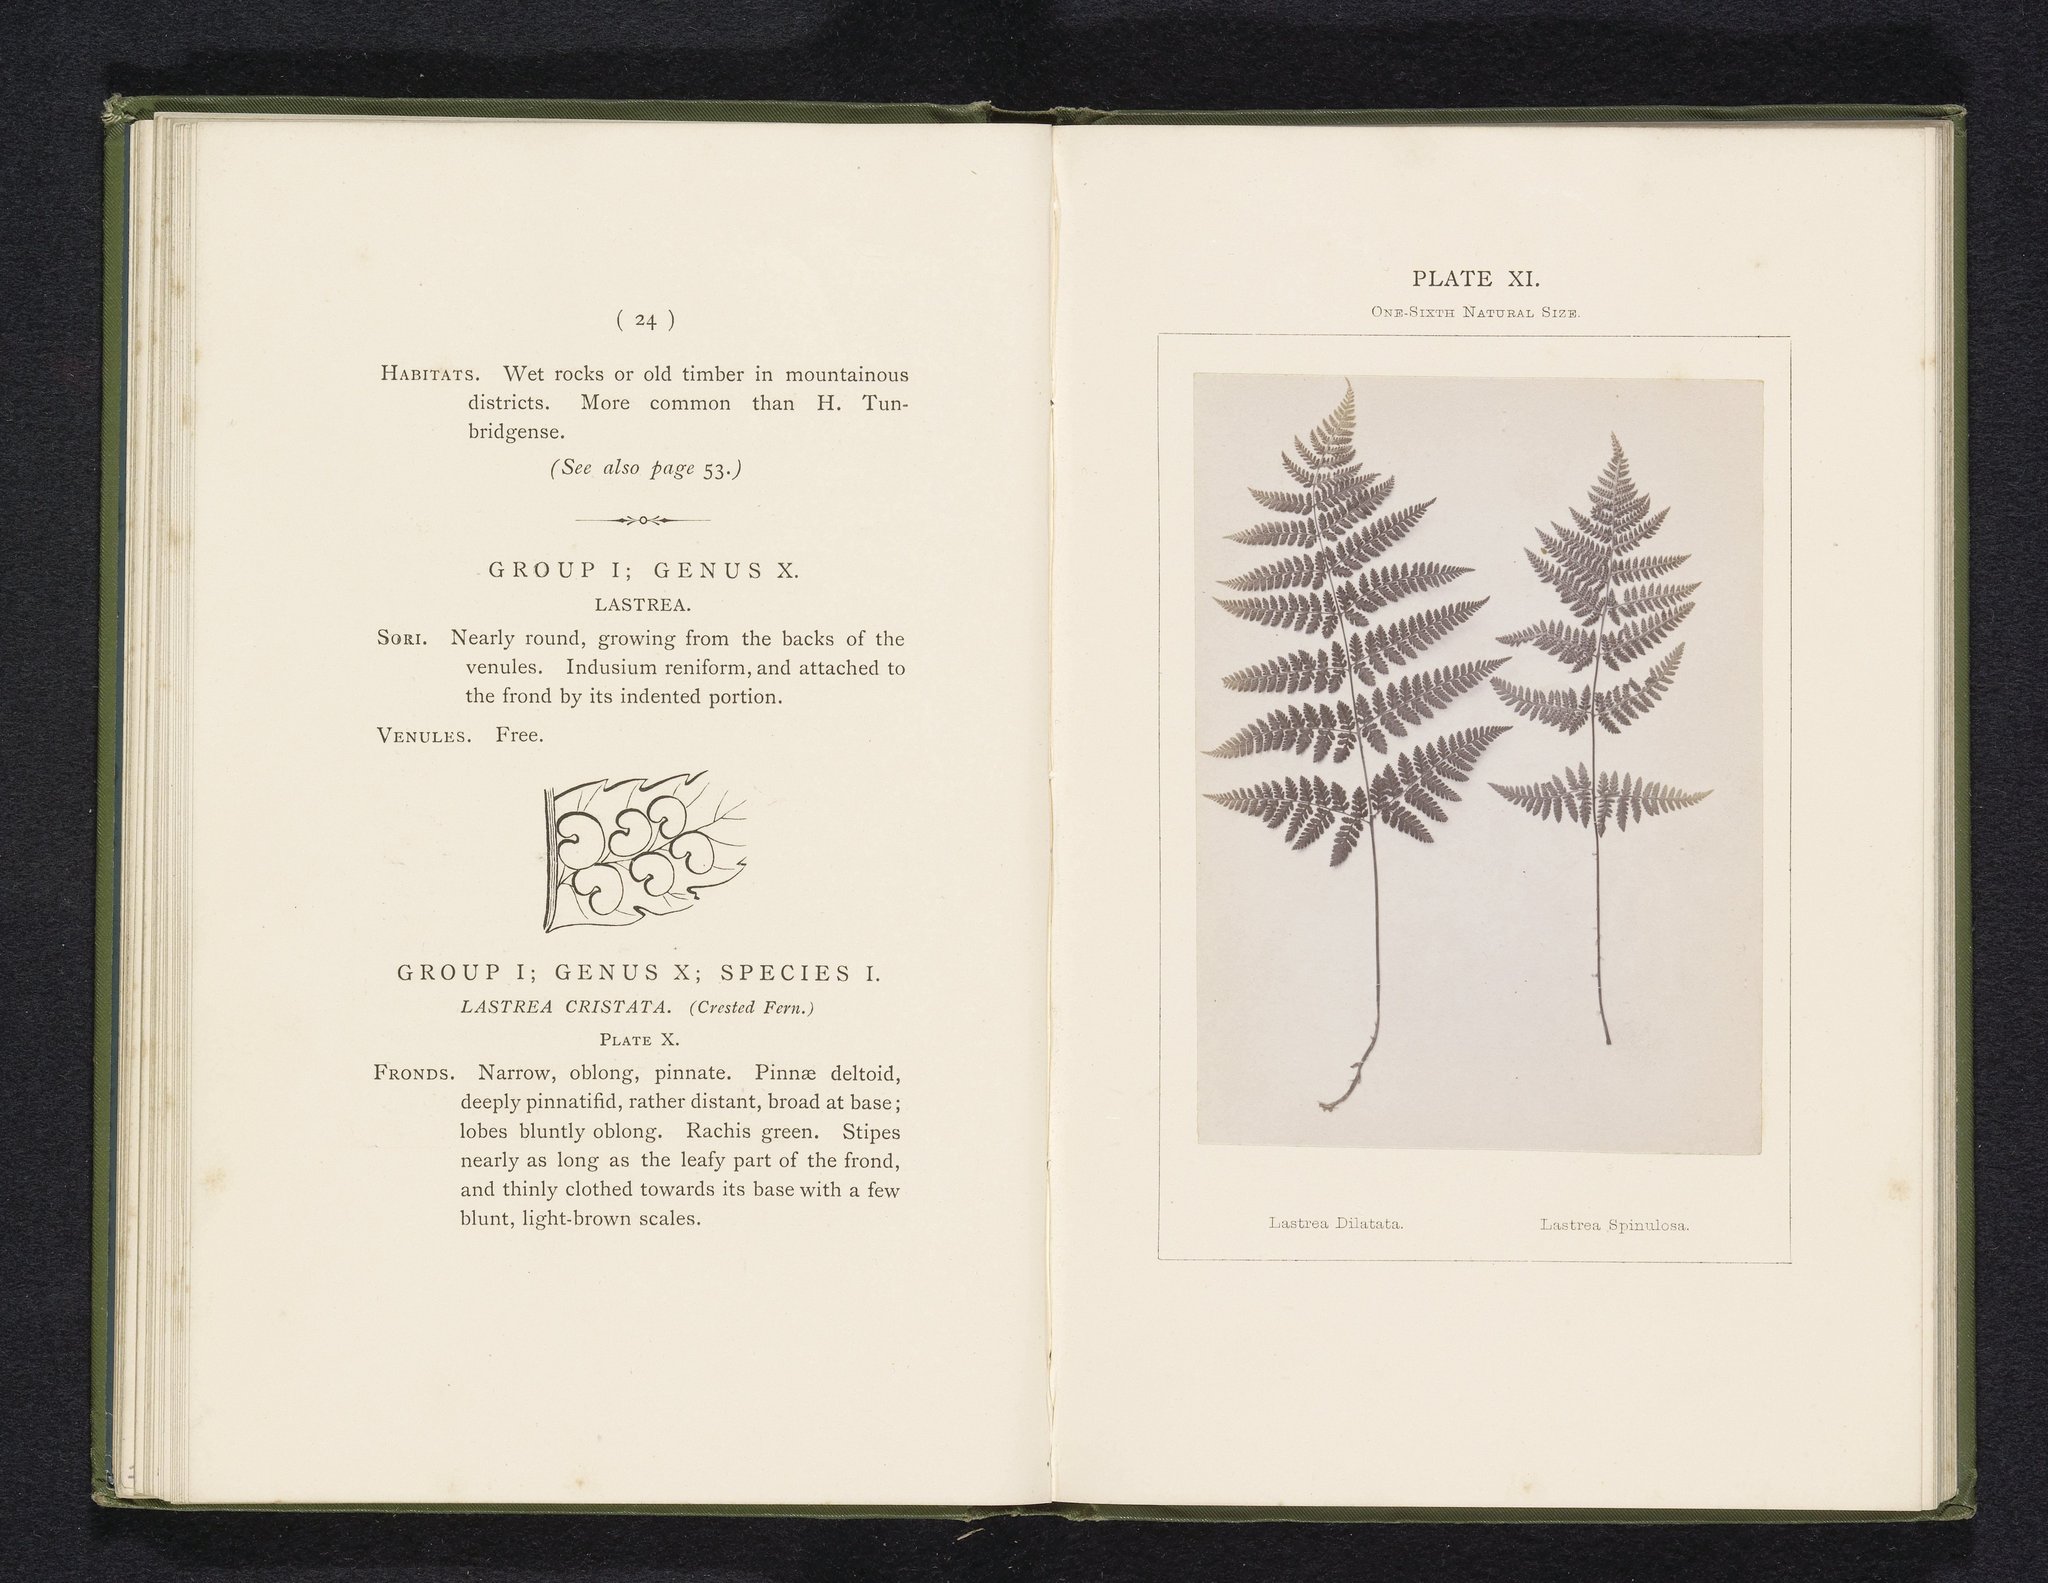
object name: photograph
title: Lastrea Dilatata. Lastrea Spinulosa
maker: sydney courtauld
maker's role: botanicus, fotograaf, schrijver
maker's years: 1840-1899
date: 1867-1877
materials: photographic support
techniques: albumen print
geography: england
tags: ferns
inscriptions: inscription: ‘Plate XI. One-sixth natural size.’